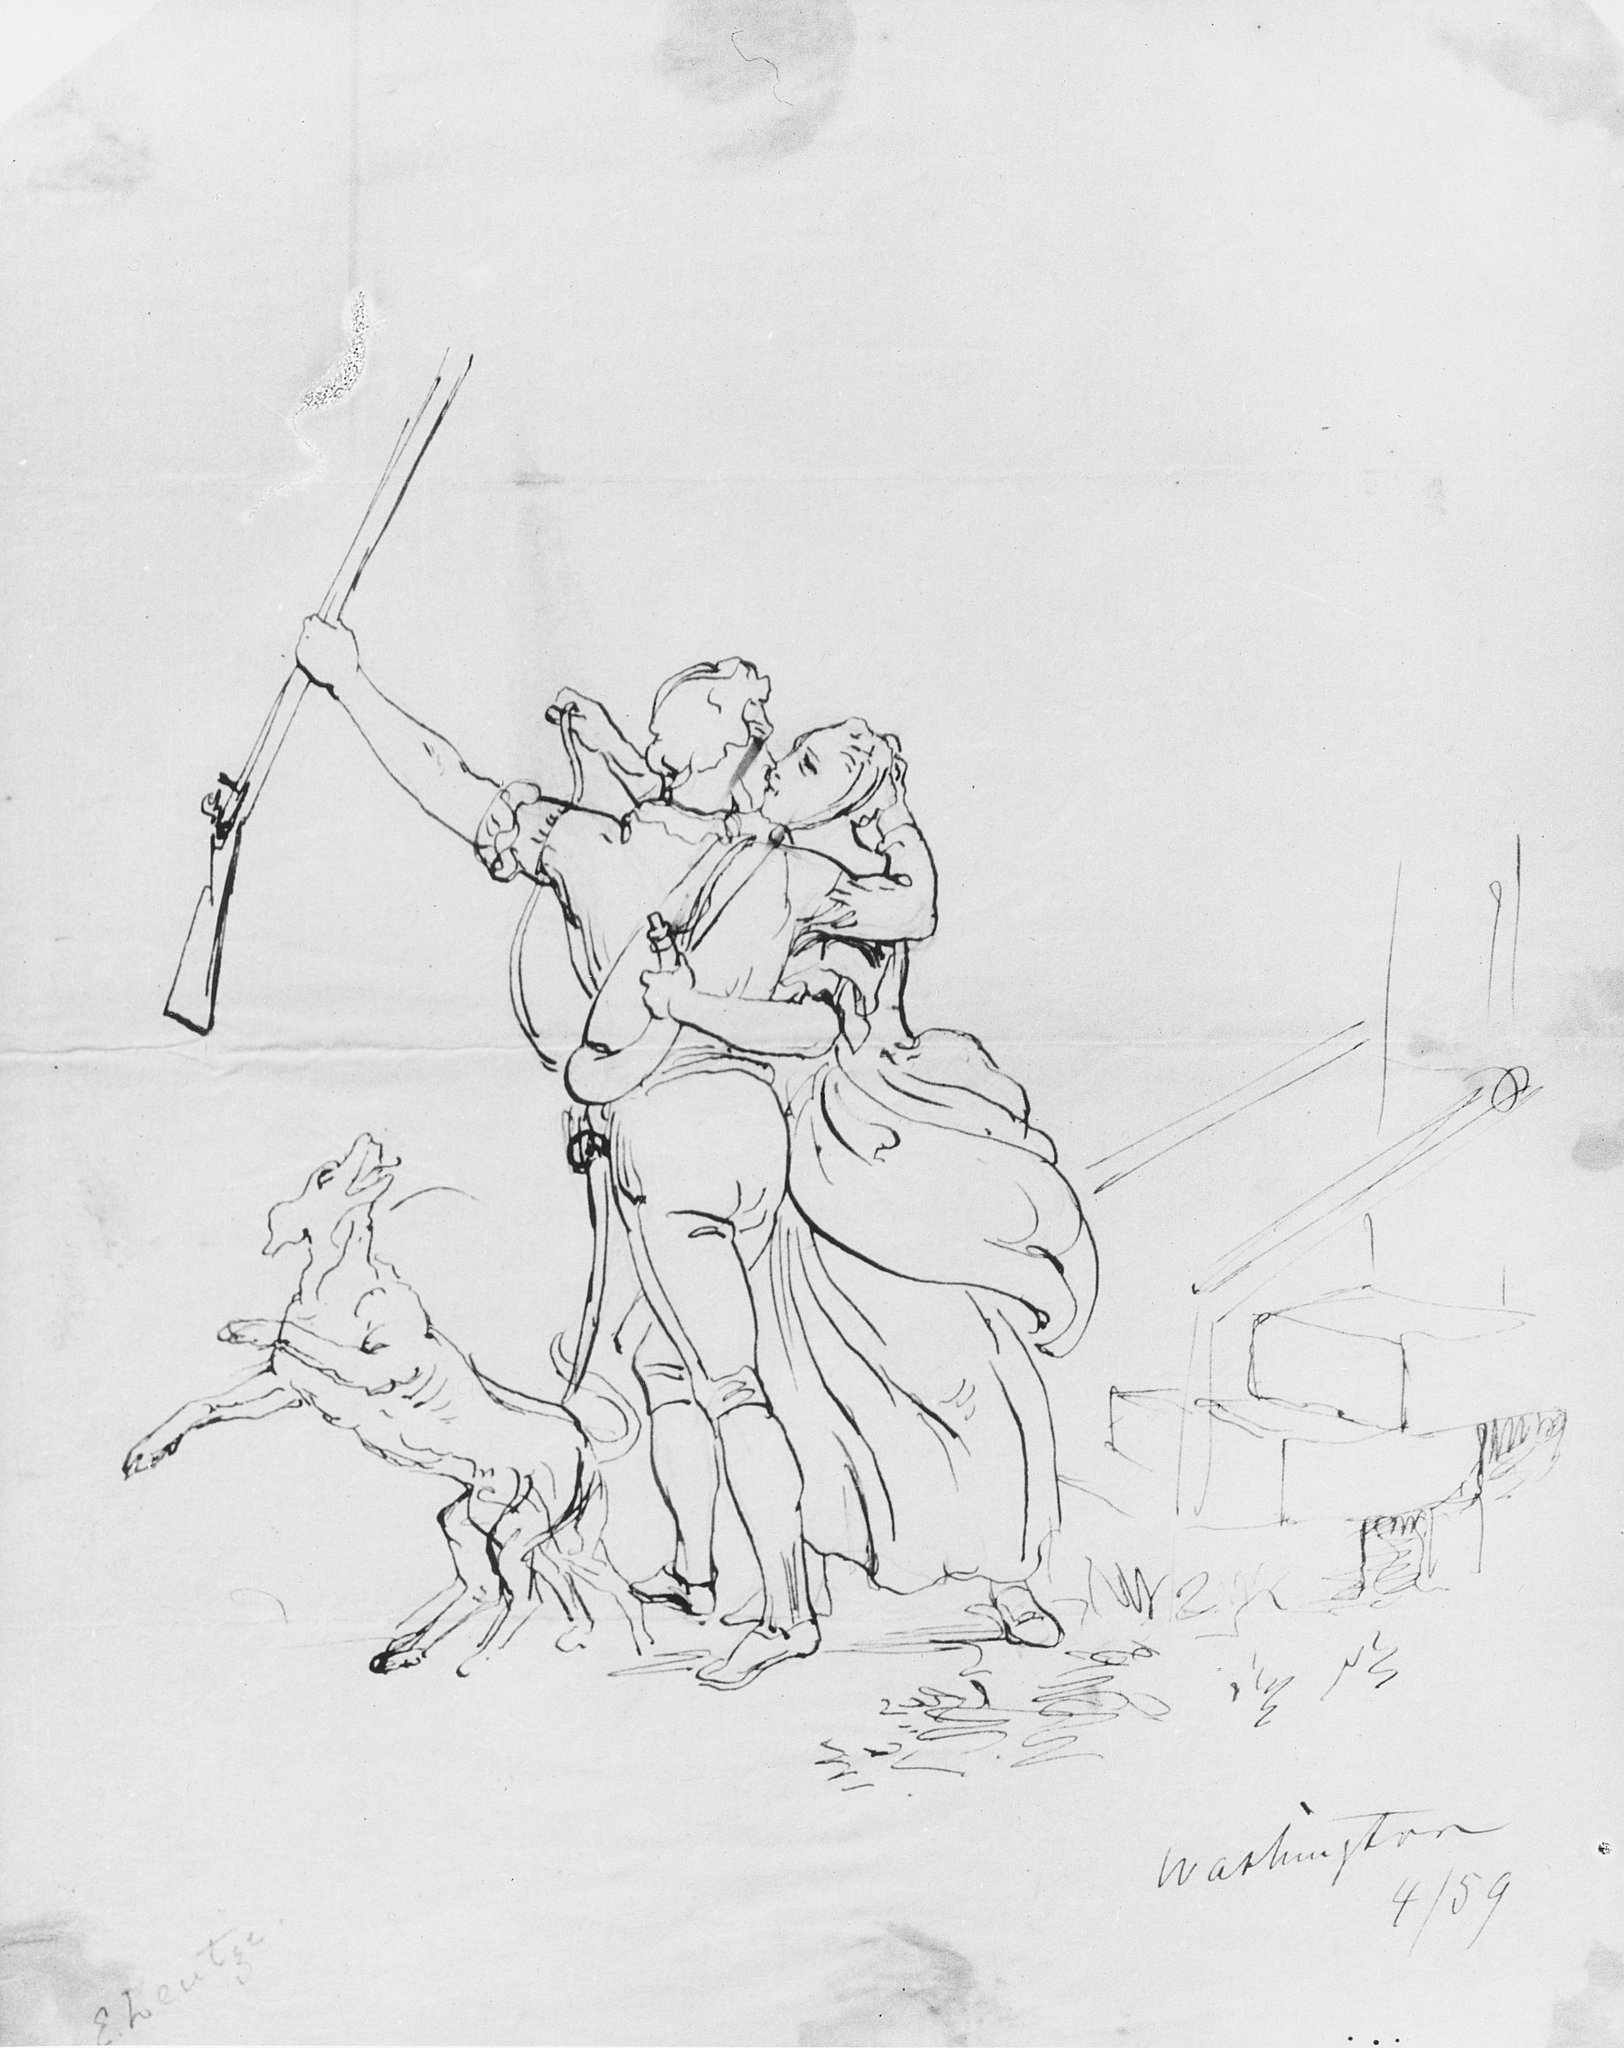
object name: drawing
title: The Soldier's Farewell (from McGuire Scrapbook)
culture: american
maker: emanuel leutze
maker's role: artist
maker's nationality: german american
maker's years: 1816-1868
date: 1859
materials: graphite, ink, paper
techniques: letterpress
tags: soldiers,firearms,women,dogs